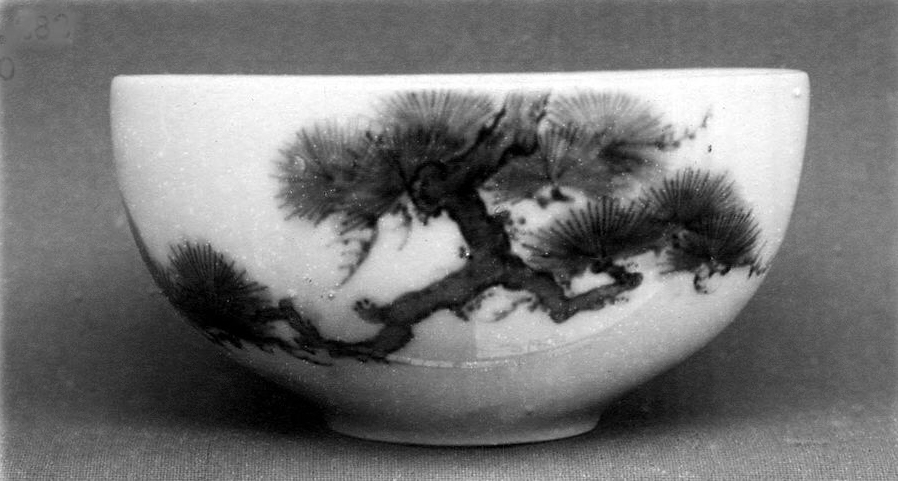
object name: bowl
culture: japanese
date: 1820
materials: glaze, porcelain